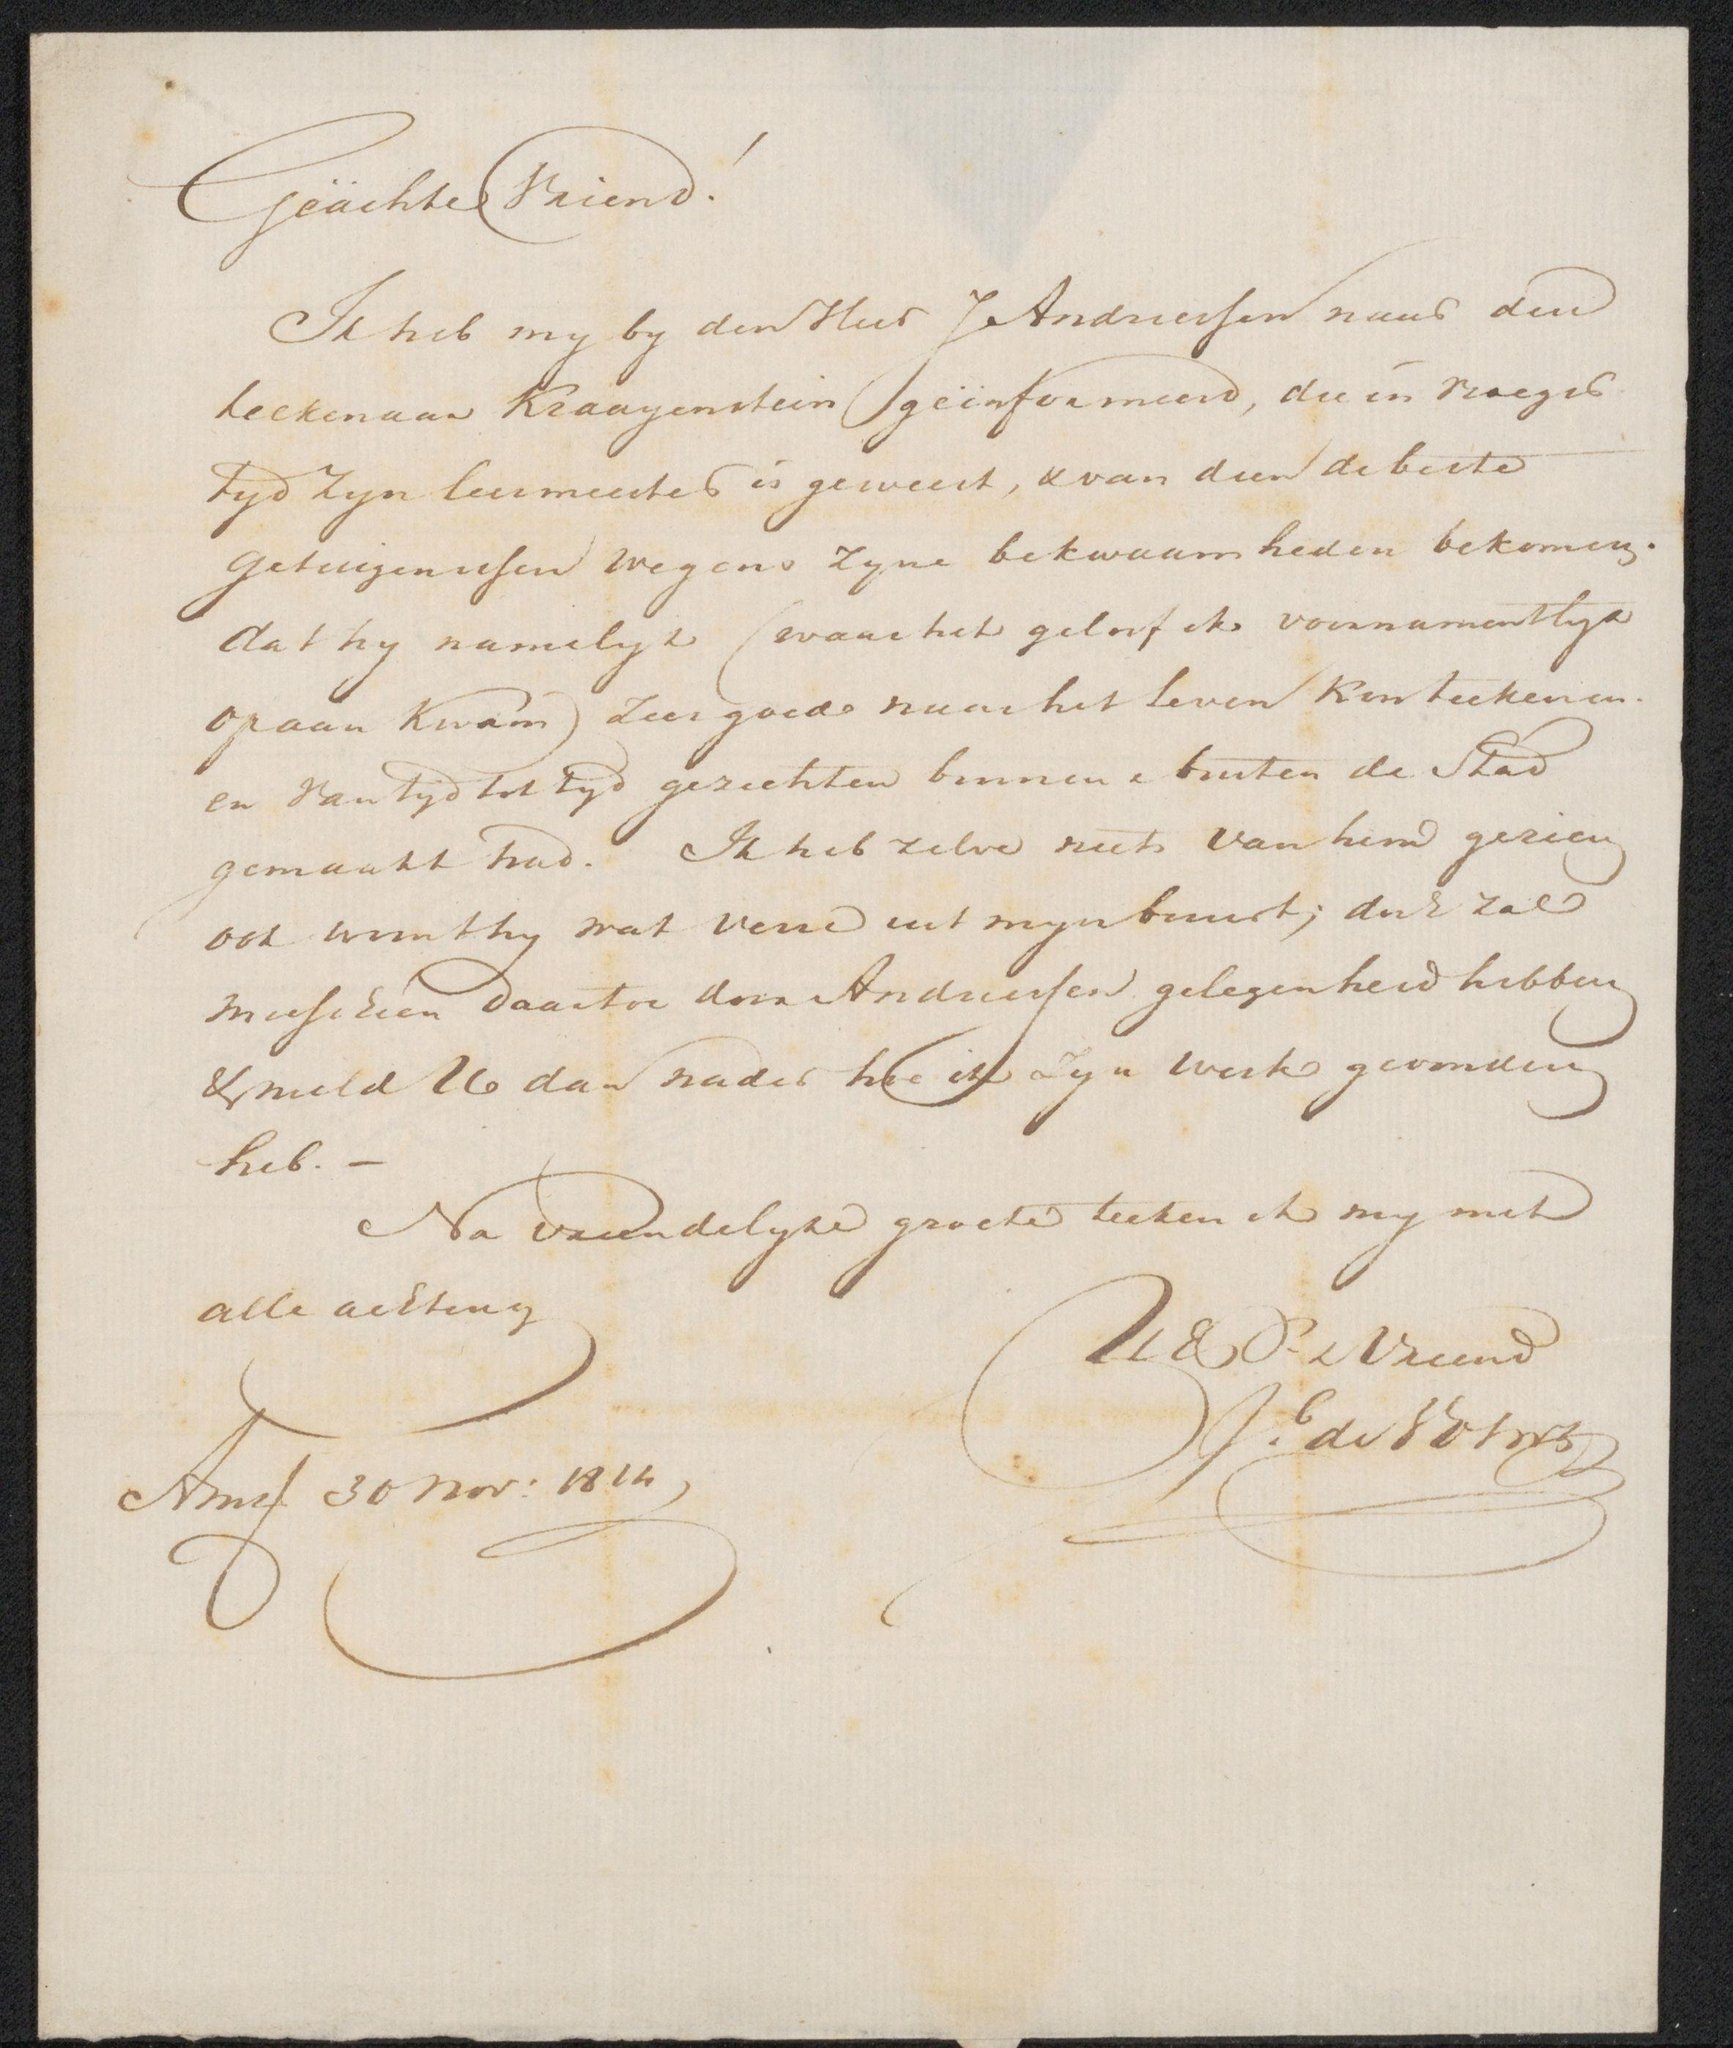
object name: letter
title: Brief aan Adriaan van der Willigen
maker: jacob de vos willemsz.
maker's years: 1774-1844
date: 1814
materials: ink, paper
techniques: pen, writing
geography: amsterdam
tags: painter, jurriaan andriessen, amsterdam, abraham krayestein, haarlem, draughtsman, adriaan van der willigen, drawing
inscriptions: watermark